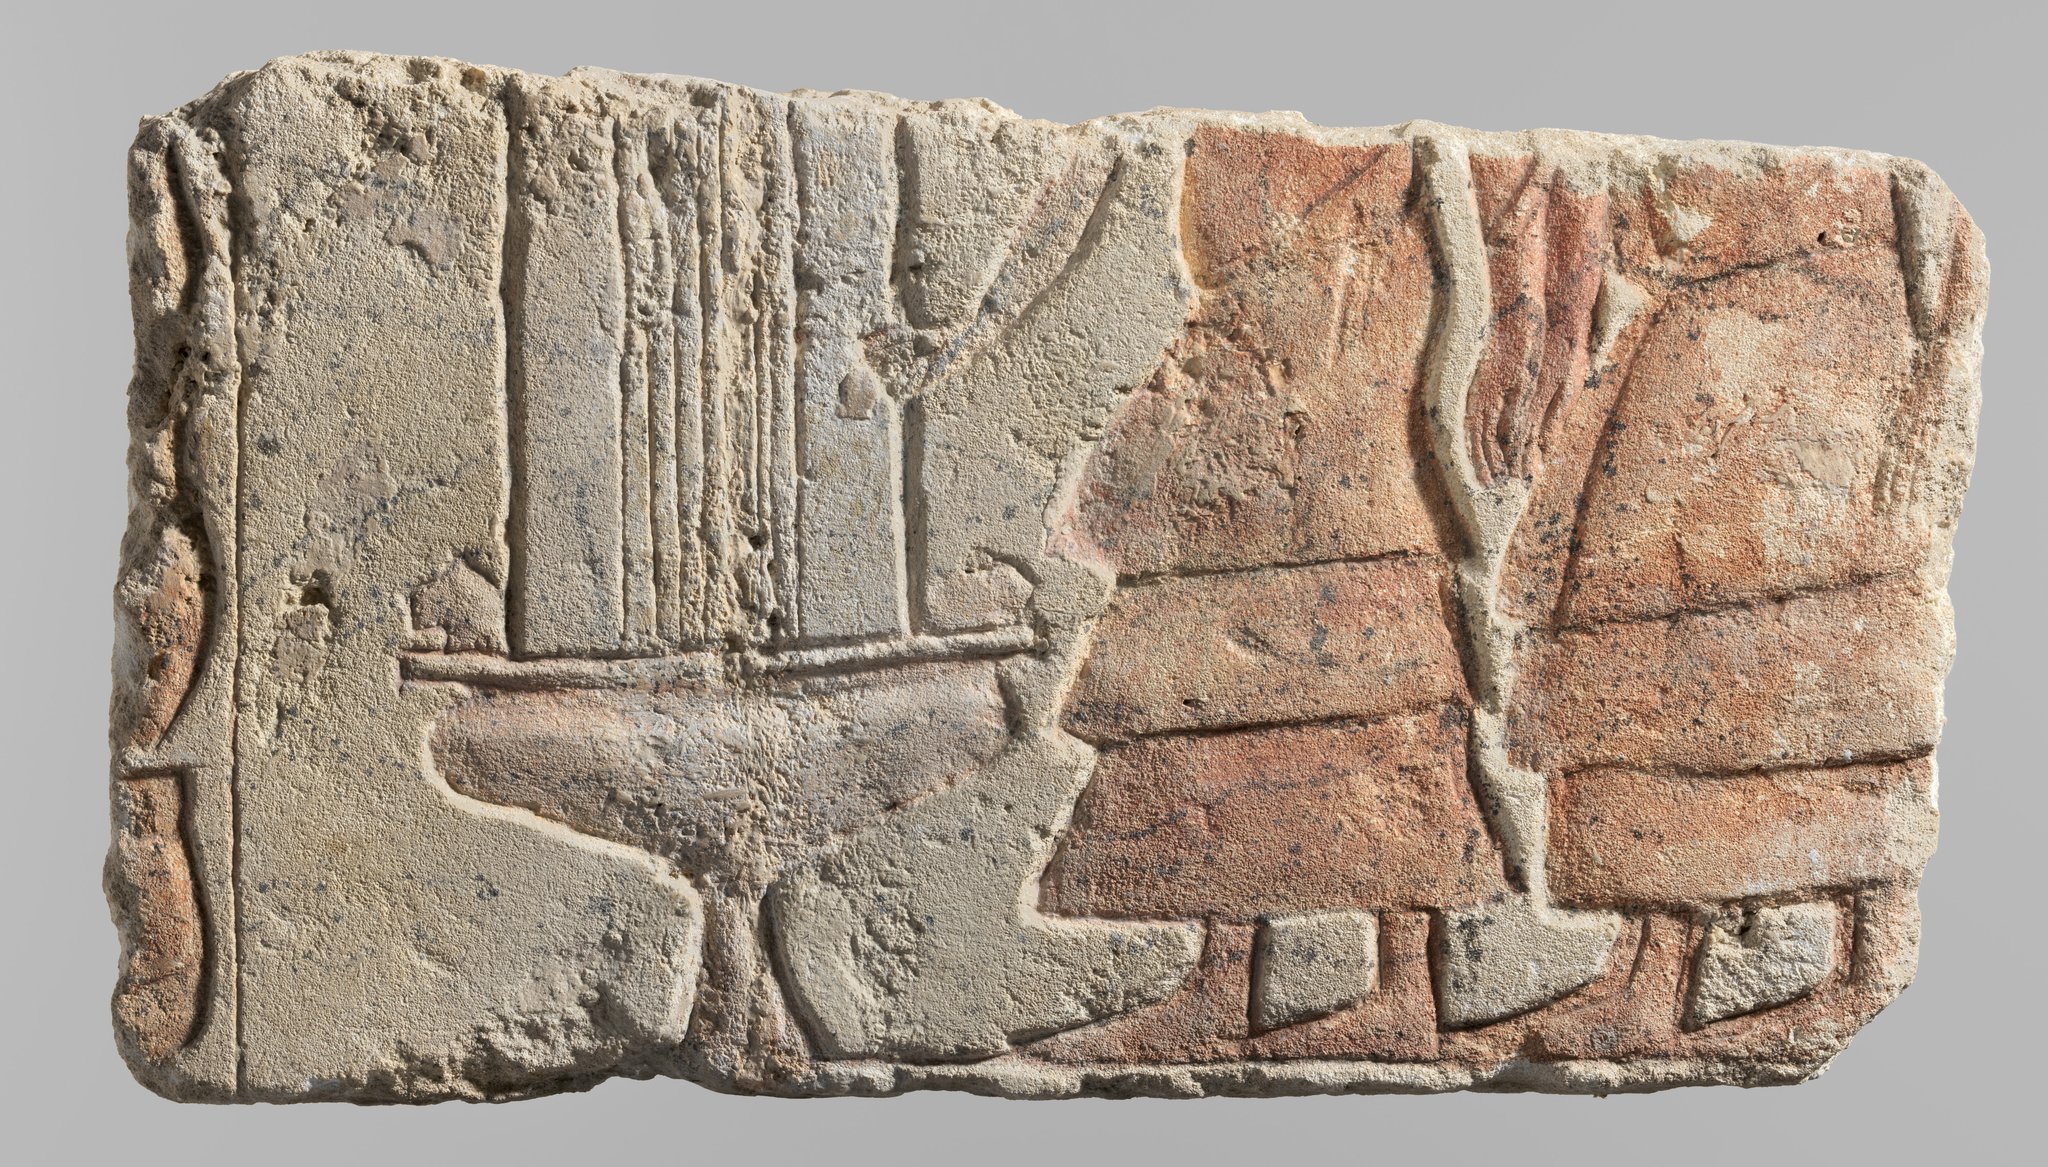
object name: talatat, foreign musician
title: Relief with foreign musicians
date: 1353-1336 BCE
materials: limestone, paint